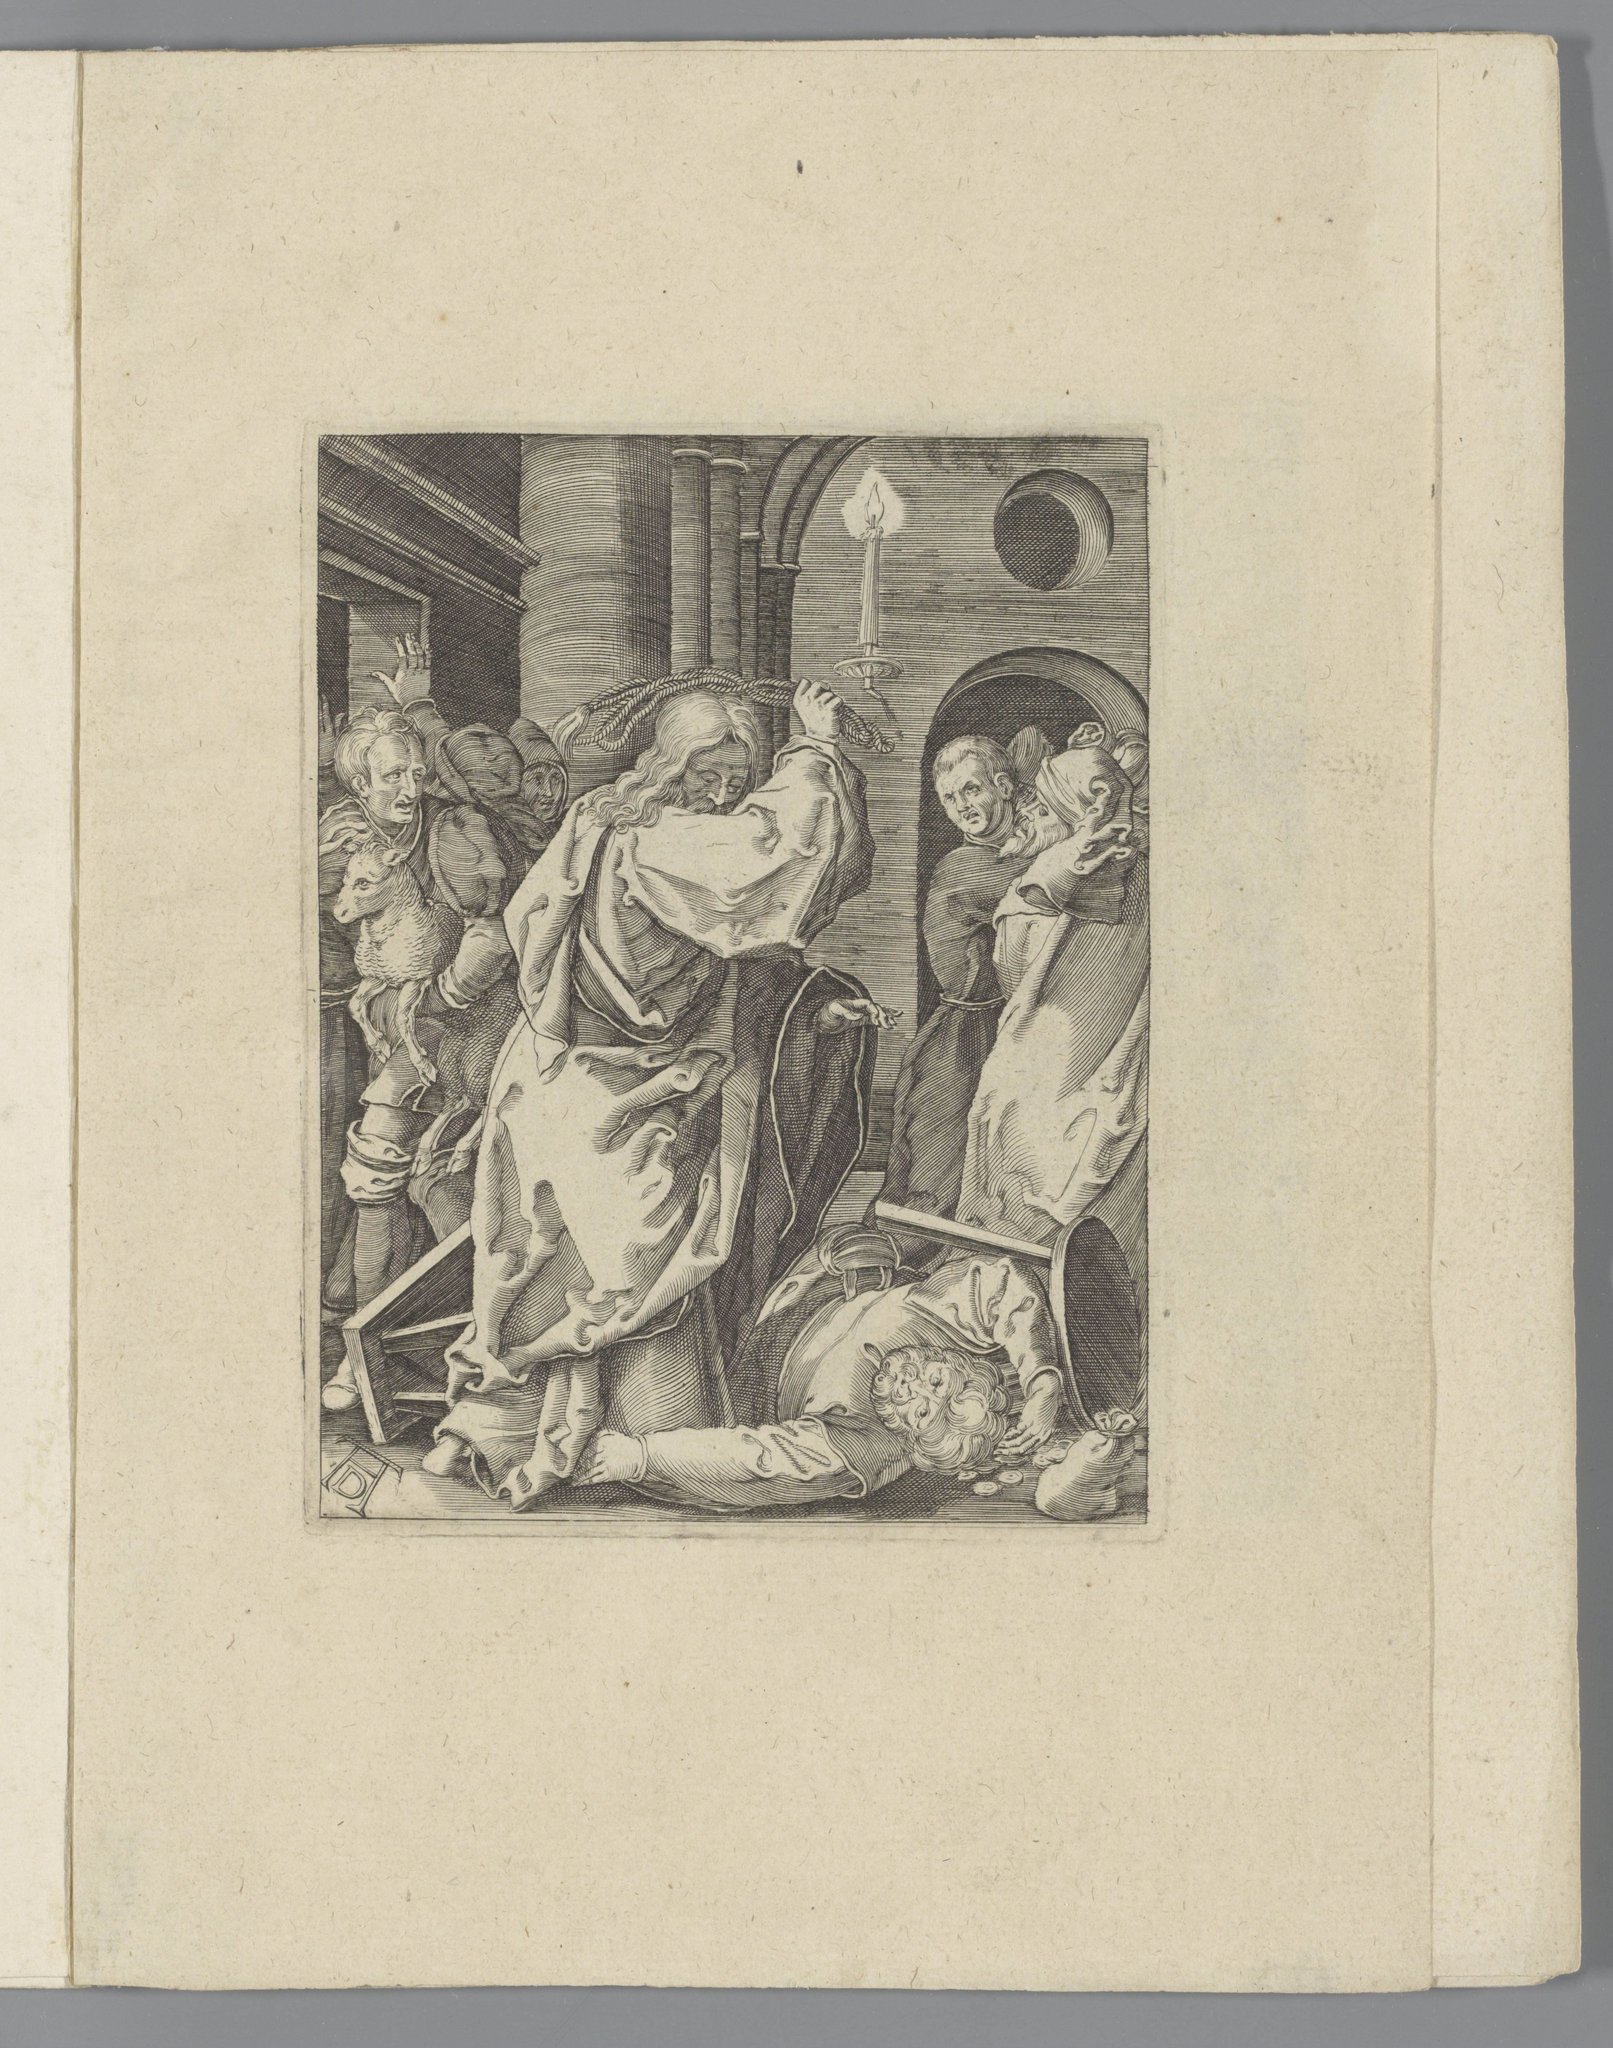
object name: album leaf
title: De kleine Passie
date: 1610-1620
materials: paper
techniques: engraving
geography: the hague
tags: purification of the temple ('first' and 'second'): christ driving the money-changers from the temple with a whip (matthew 21:12-13; mark 11:15-17; luke 19:45-46; john 12:12-19)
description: Christus verdrijft met een zweep de geldwisselaars uit de tempel. Prent maakt deel uit van een album.